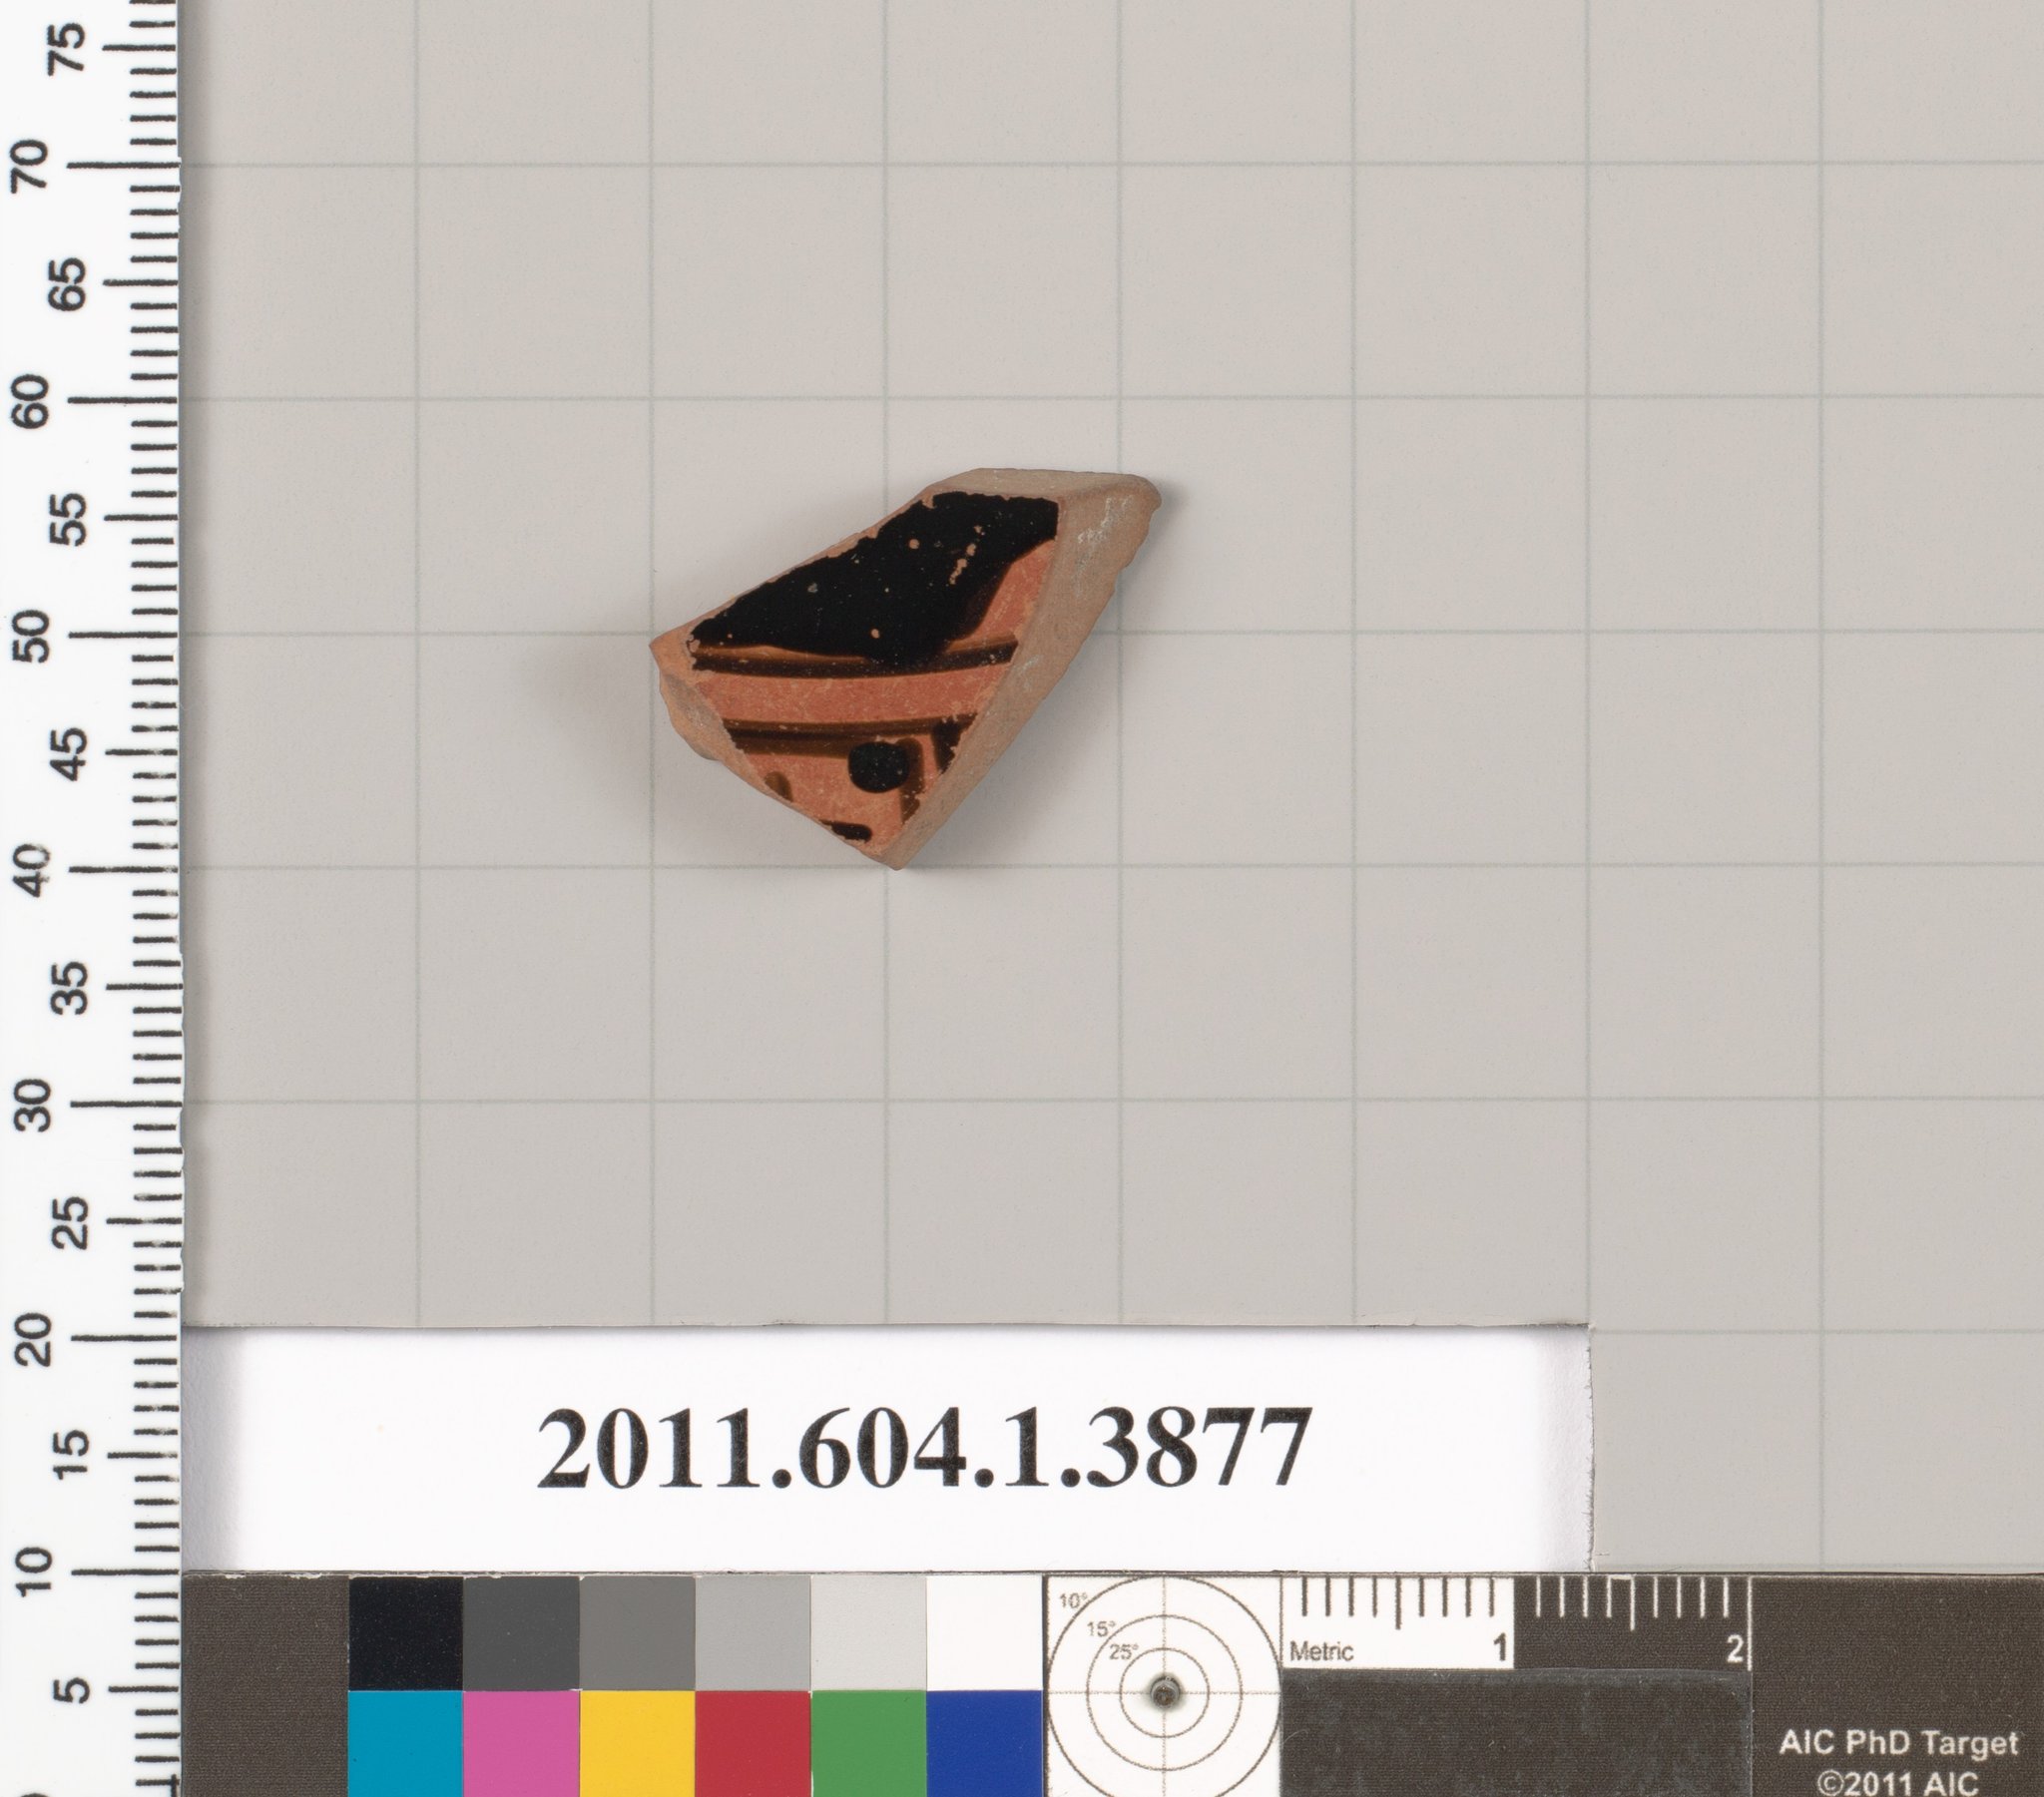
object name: kylix fragment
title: Terracotta fragment of a kylix (drinking cup)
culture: greek, attic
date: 475-451 BCE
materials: terracotta